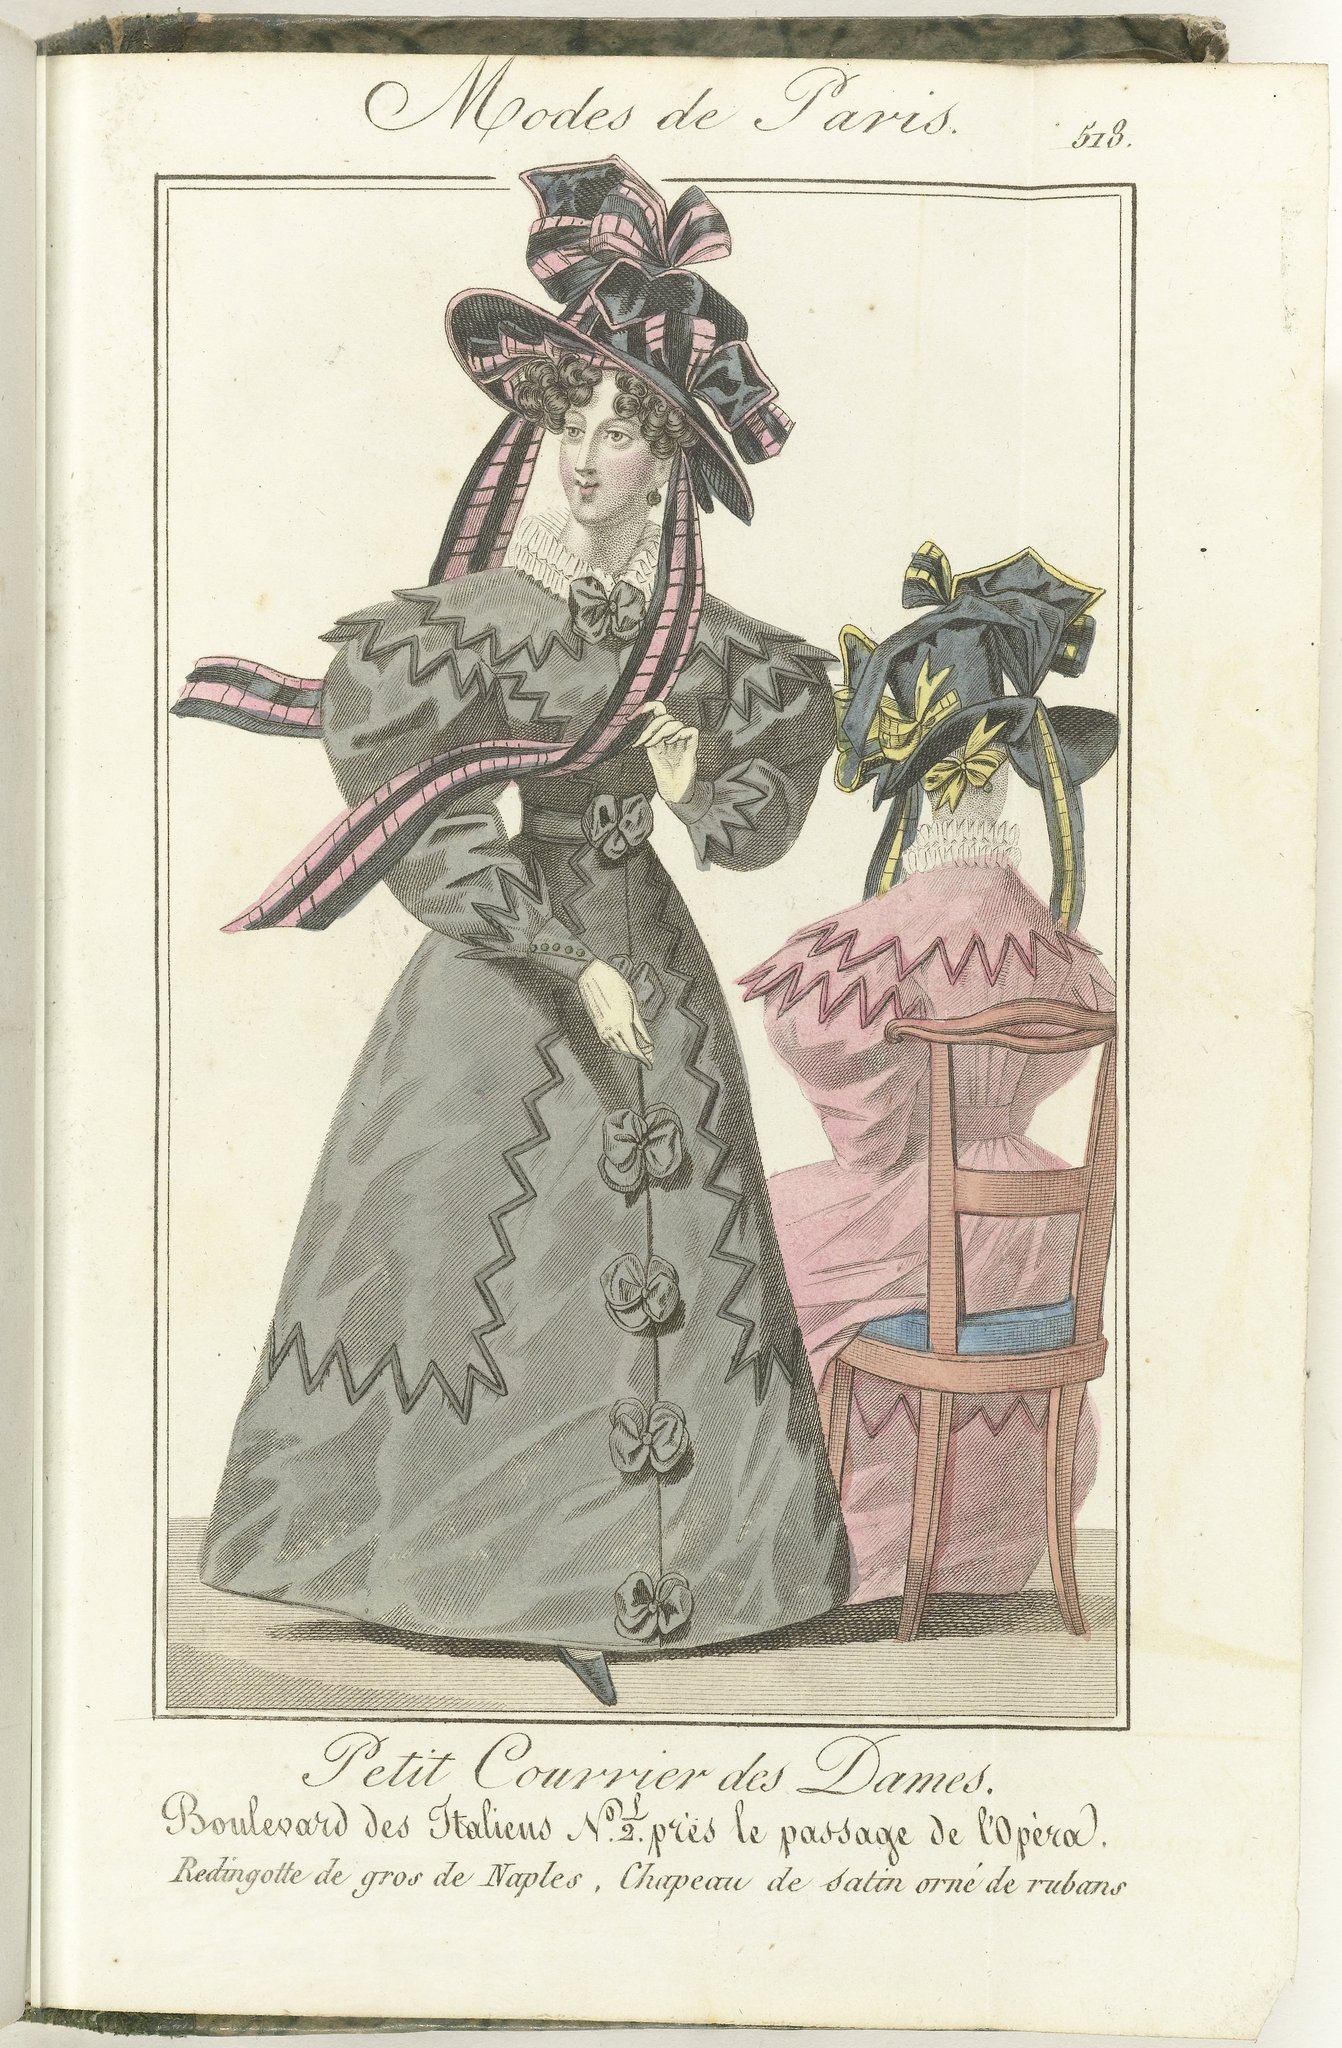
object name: fashion print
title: Petit Courrier des Dames, 10 décembre 1827, No. 518 : Redingotte de gros de Naples...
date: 1827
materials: paper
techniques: engraving, hand coloring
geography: paris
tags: border, ribbon, braid (+ women's clothes), dress, gown: redingote (+ women's clothes), fashion plates, head-gear: hat (+ women's clothes)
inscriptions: caption: ‘Redingotte de gros de Naples. Chapeau de satin orné de rubans’, address: ‘Boulevard des Italiens No.2 près le passage de l'Opèra.’, title: ‘Petit Courrier des Dames.’, title: ‘Modes de Paris.’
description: Staande vrouw gekleed in een redingote van gros de Naples. Op het hoofd een hoed van satijn versierd met linten. Zittende figuur in eenzelfde redingote, op de rug gezien. Prent uit het modetijdschrift Petit Courrier des Dames (1821-1868). Ingebonden (met enkele pp. Le Journal des Dames et des Modes). 15 Januari 1827 t/m 20 maart 1830. Incompleet.